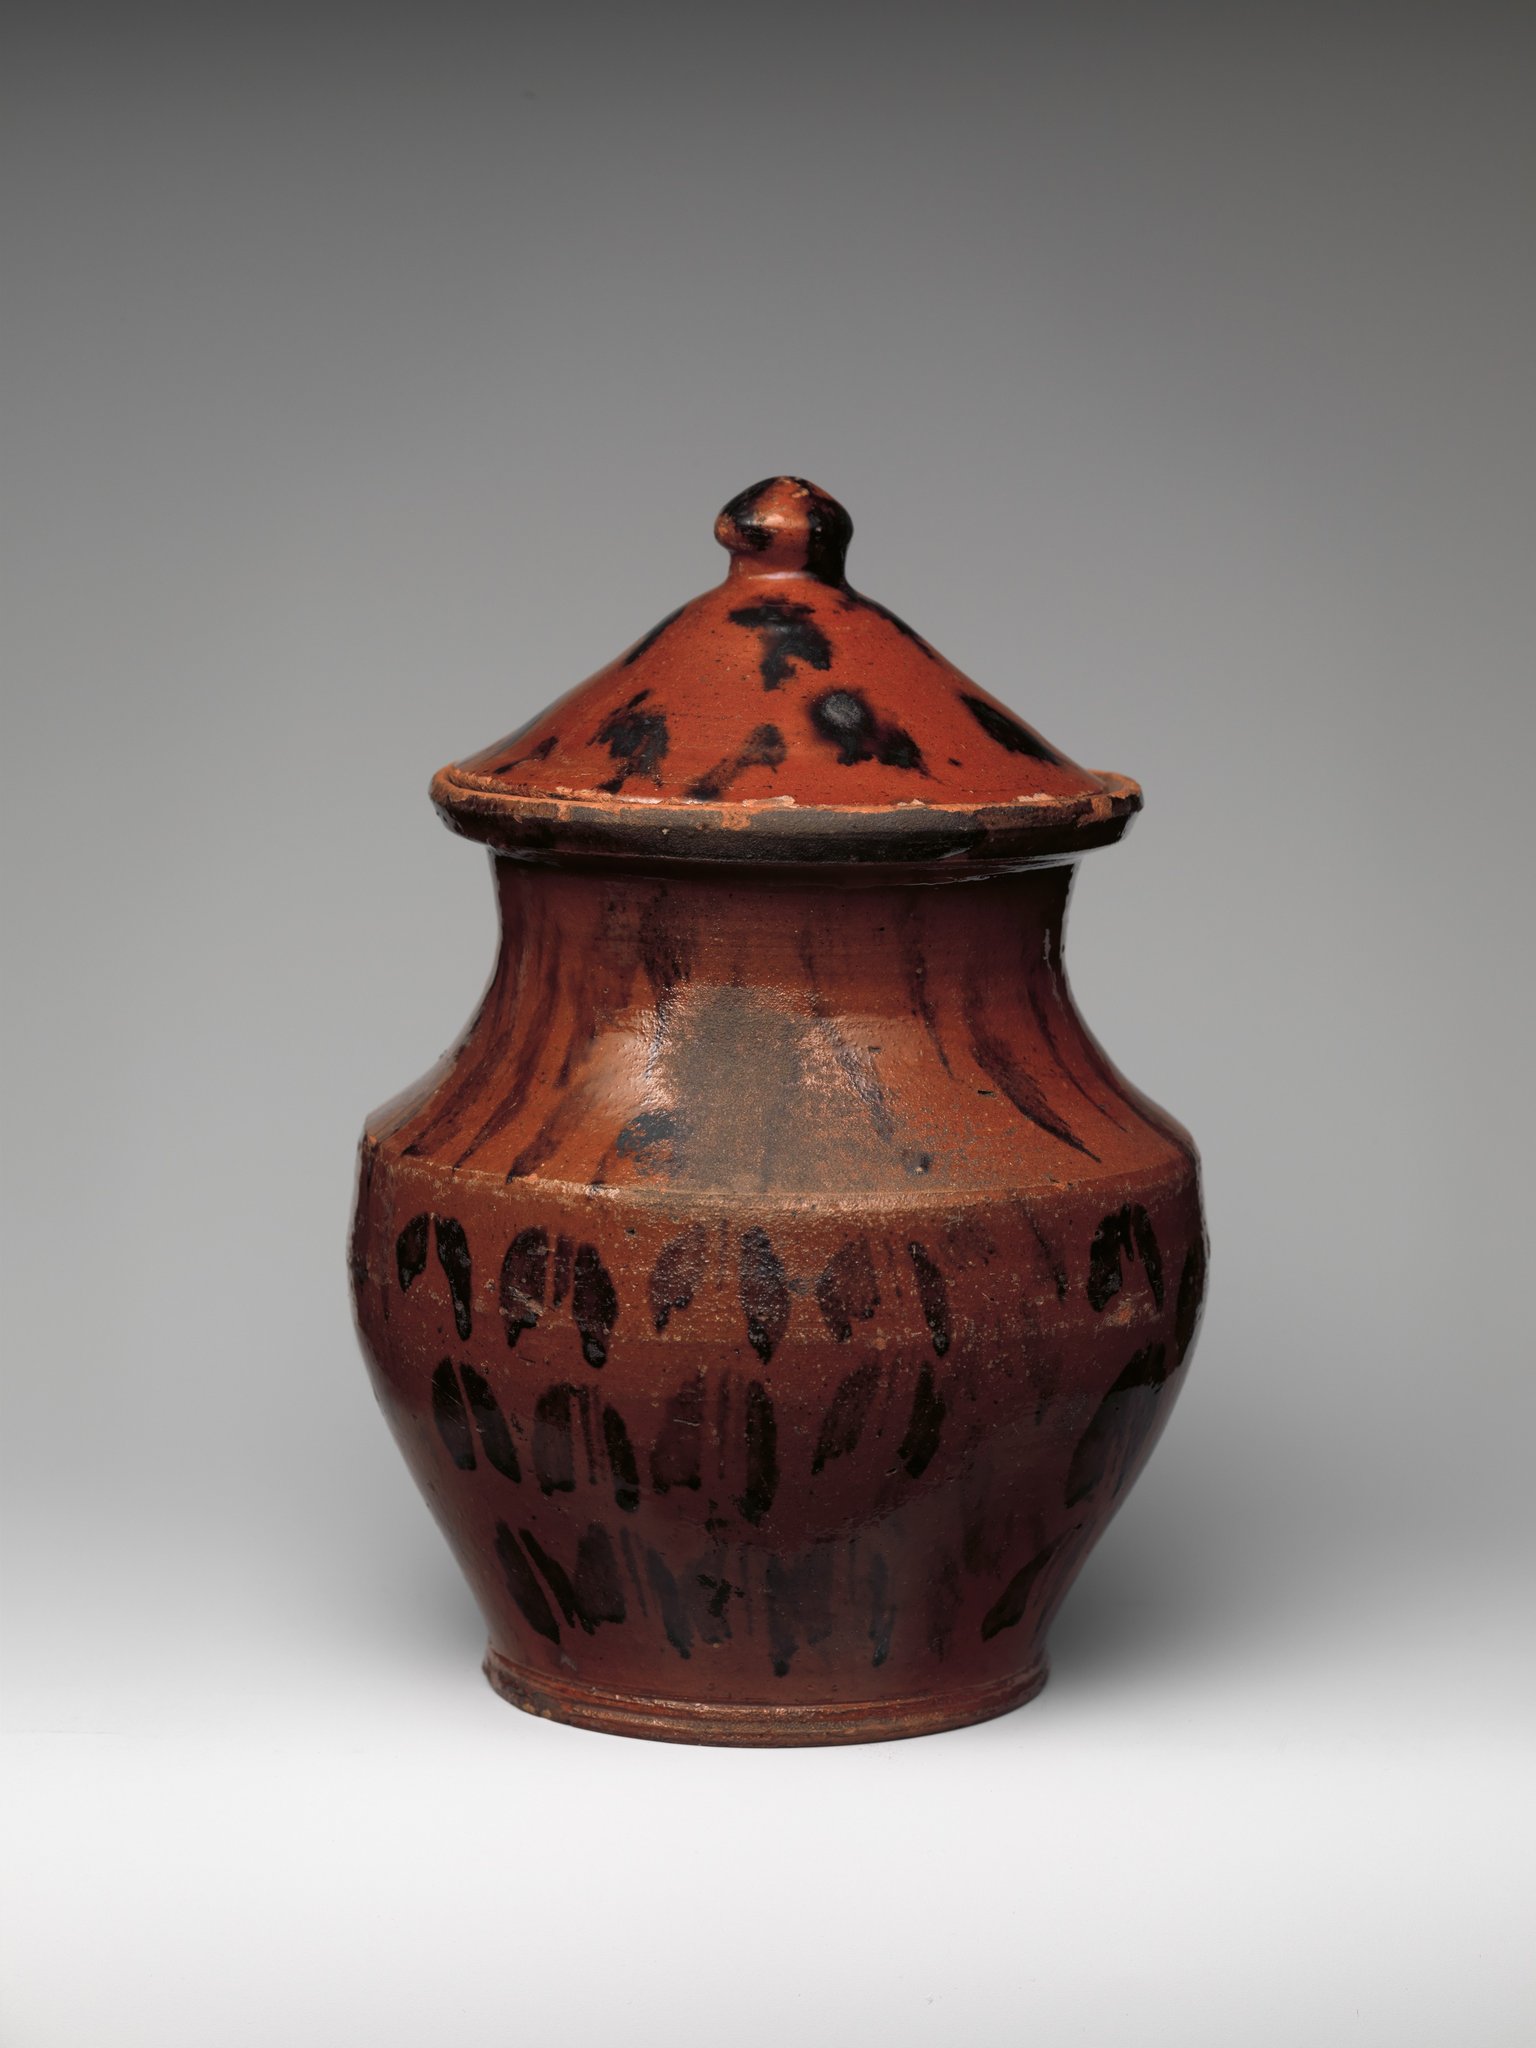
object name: tobacco jar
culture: american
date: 1800-1900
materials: earthenware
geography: united states